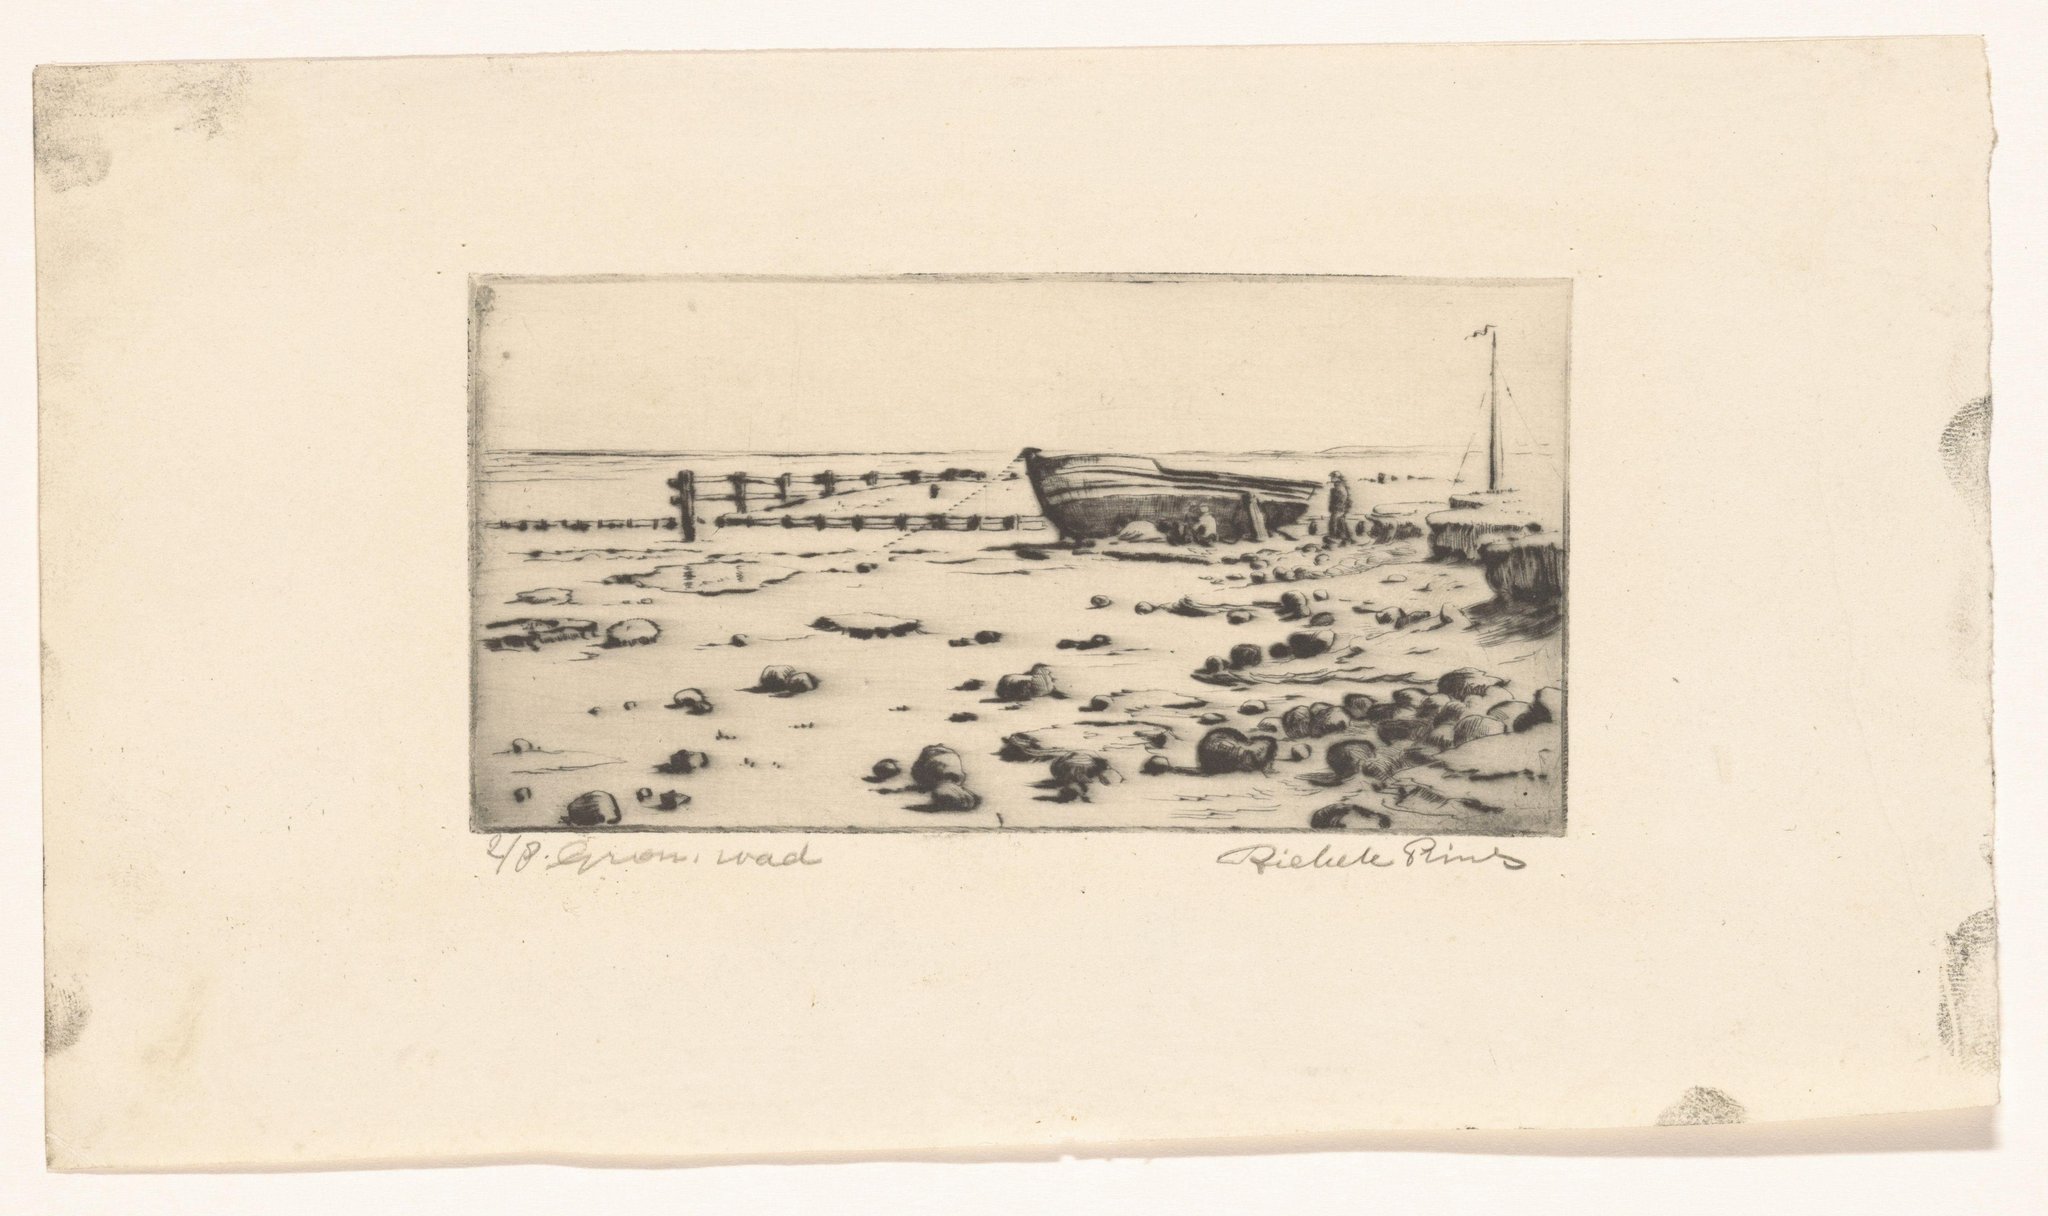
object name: print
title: Gezicht op het wad in Groningen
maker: riekele prins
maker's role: print maker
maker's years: 1905-1954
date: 1915-1941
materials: paper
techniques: drypoint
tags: mud flat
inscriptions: collector's mark: Lugt 2760, collector's mark: Lugt 2228